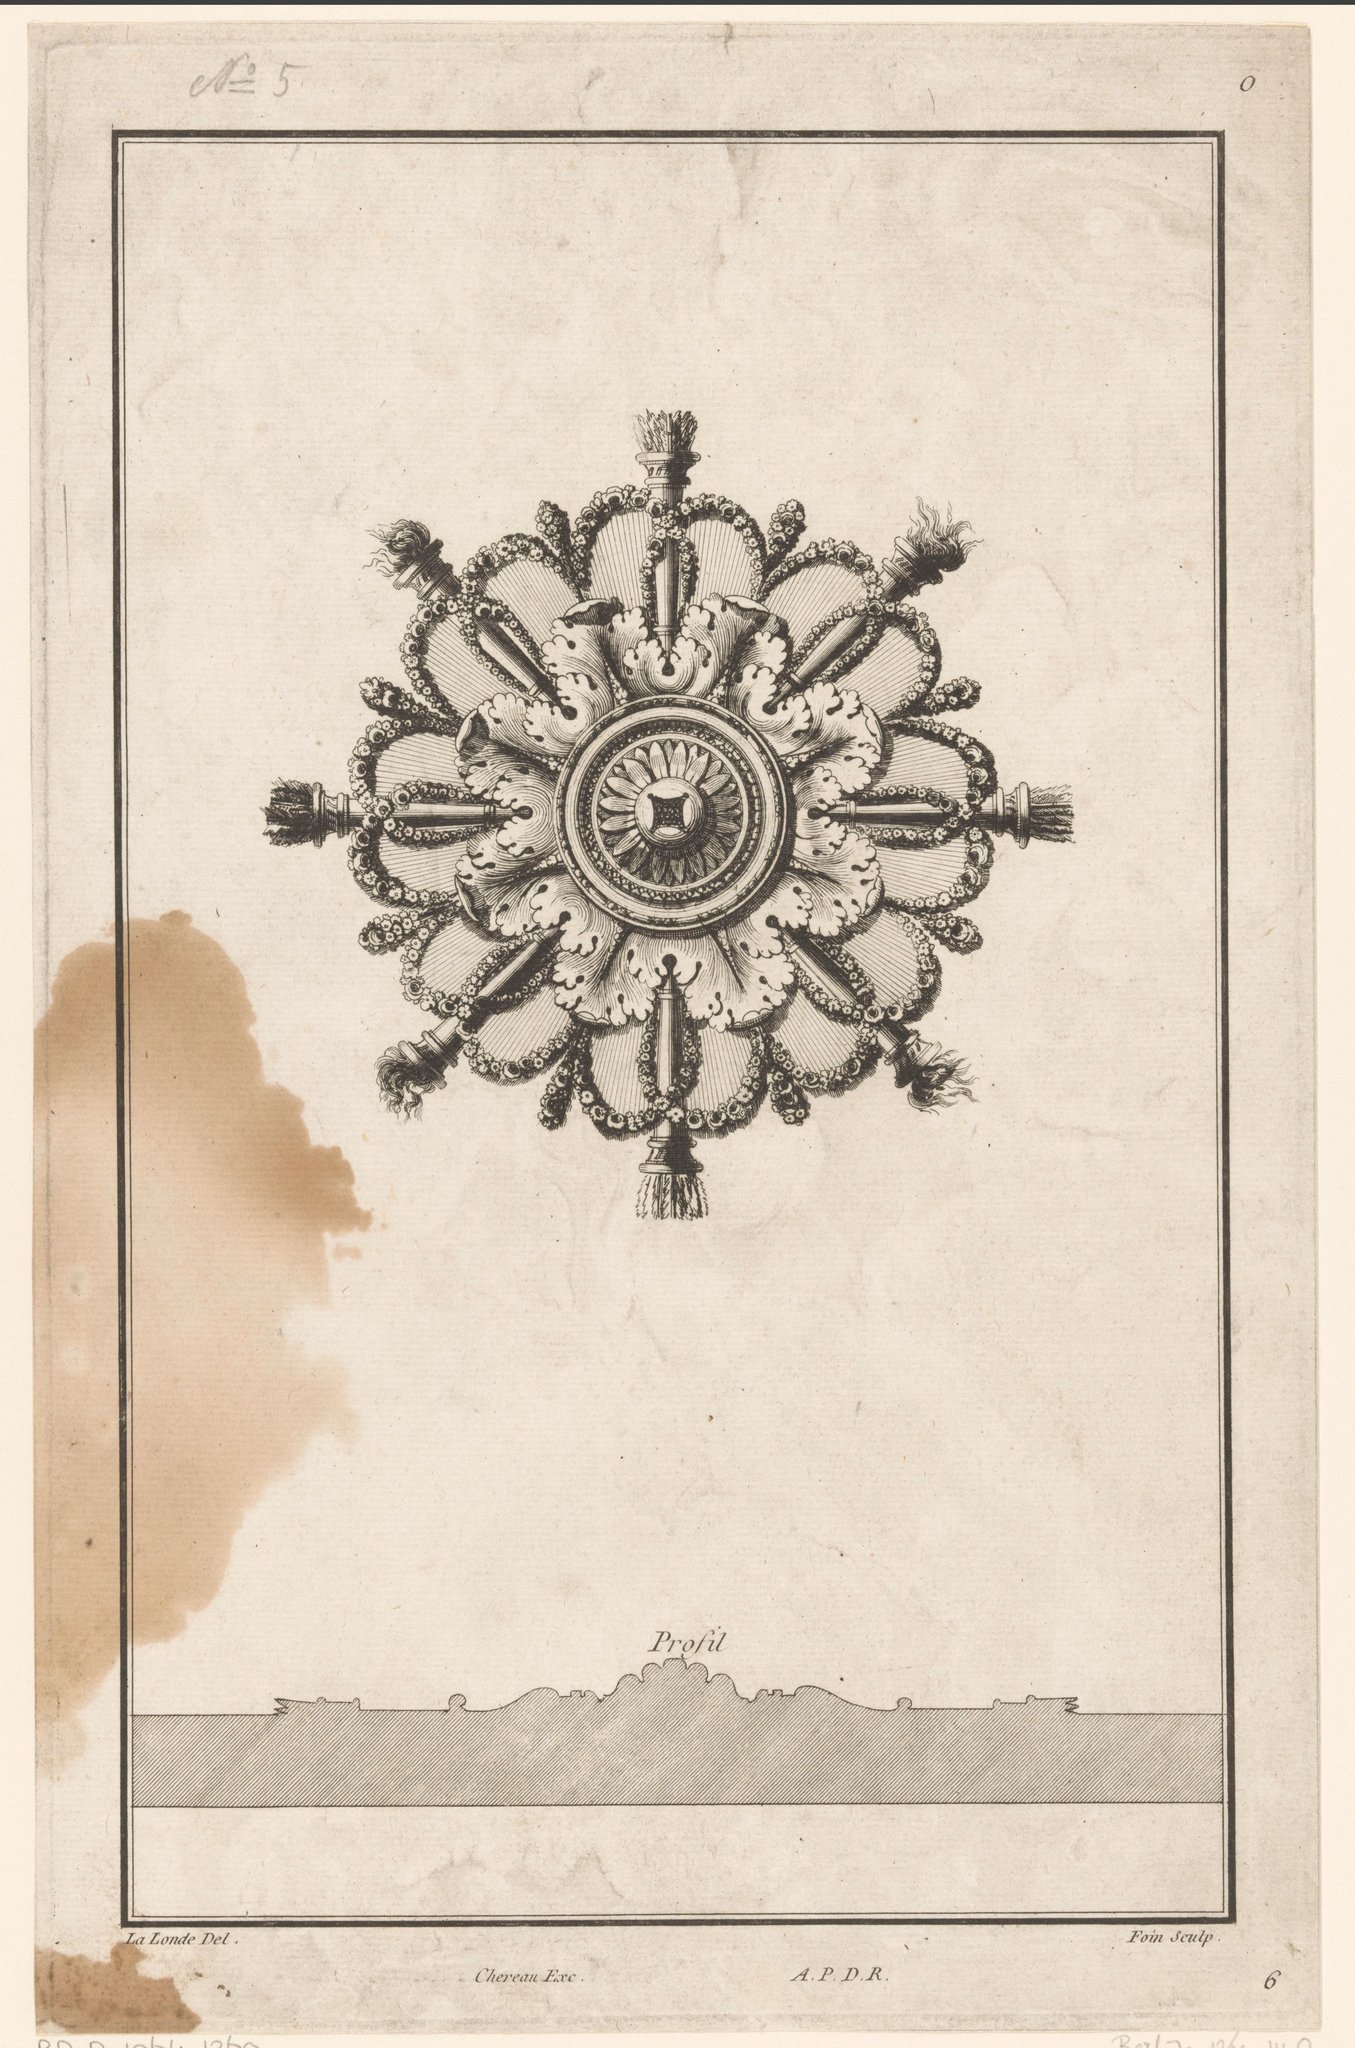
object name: ornament print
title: XIVe Cahier de l'Oeuvre de La Londe O Rosettes de Plafonds avec leurs Profils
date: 1784-1785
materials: paper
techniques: engraving, etching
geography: paris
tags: quiver, rosette ~ ornament, torch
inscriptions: collector's mark: Lugt 2760, collector's mark: Lugt 2228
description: Rozet met bloemmotief, acanthusbladeren, bloemenguirlandes en fakkels en pijlenkokers. Daaronder het profiel van de rozet.